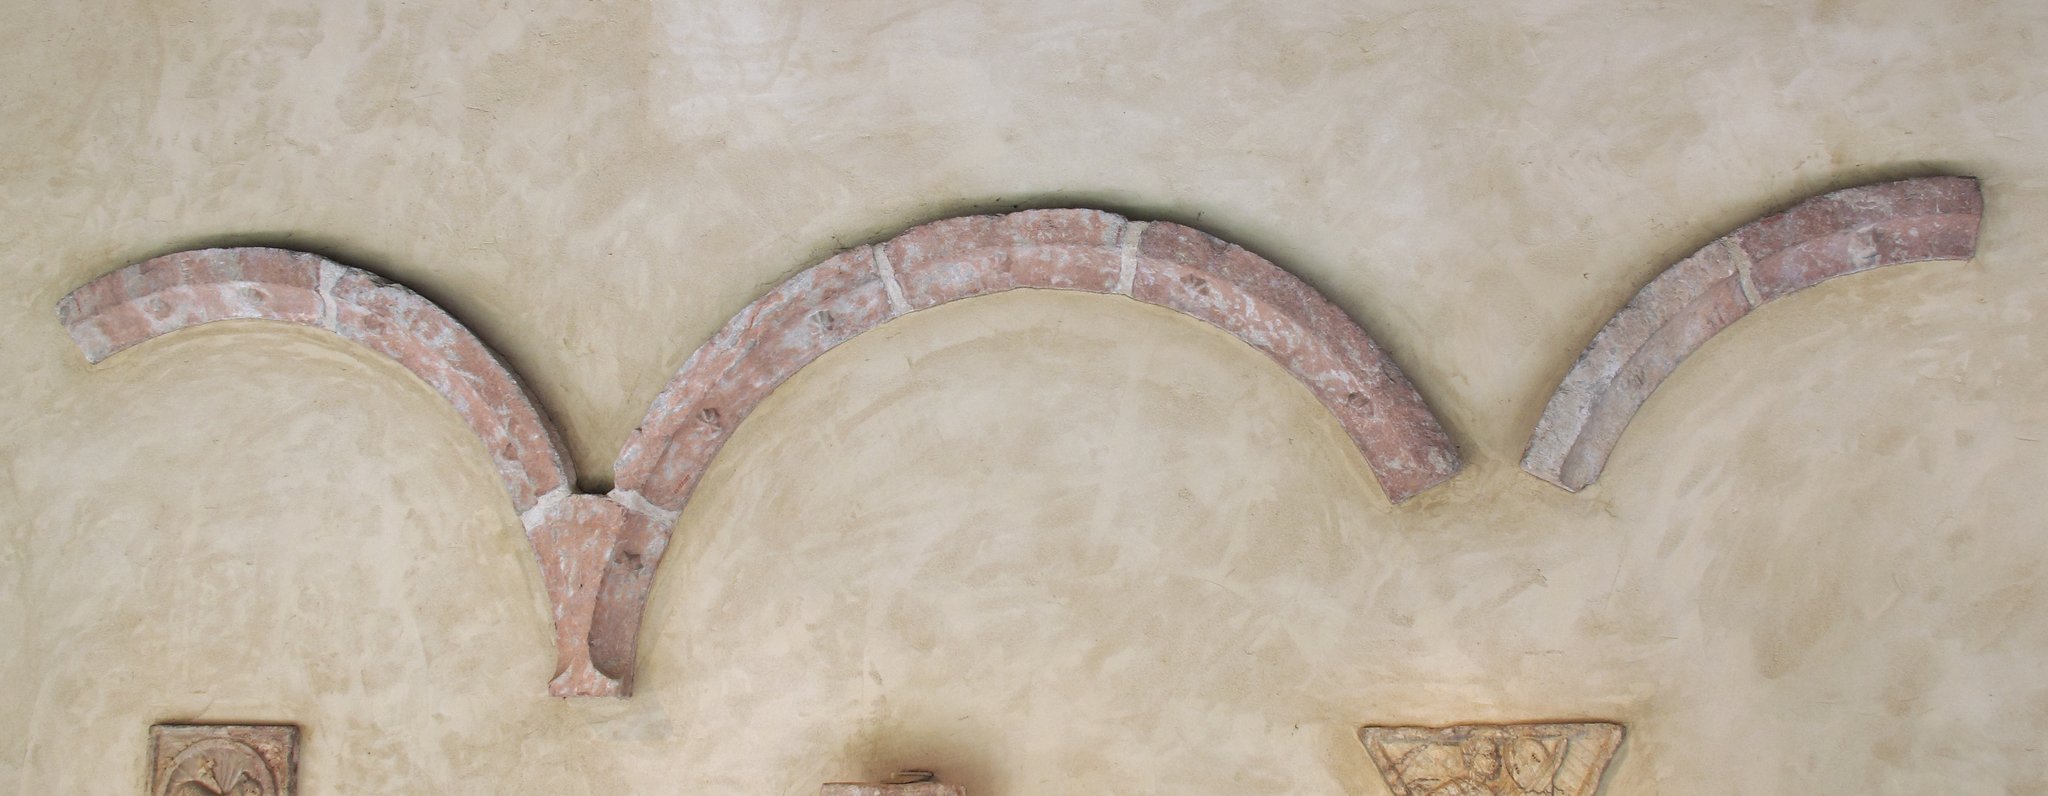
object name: spandrel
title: Spandrel with Sections of an Arch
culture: catalan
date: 1130-1140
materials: marble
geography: france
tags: arches